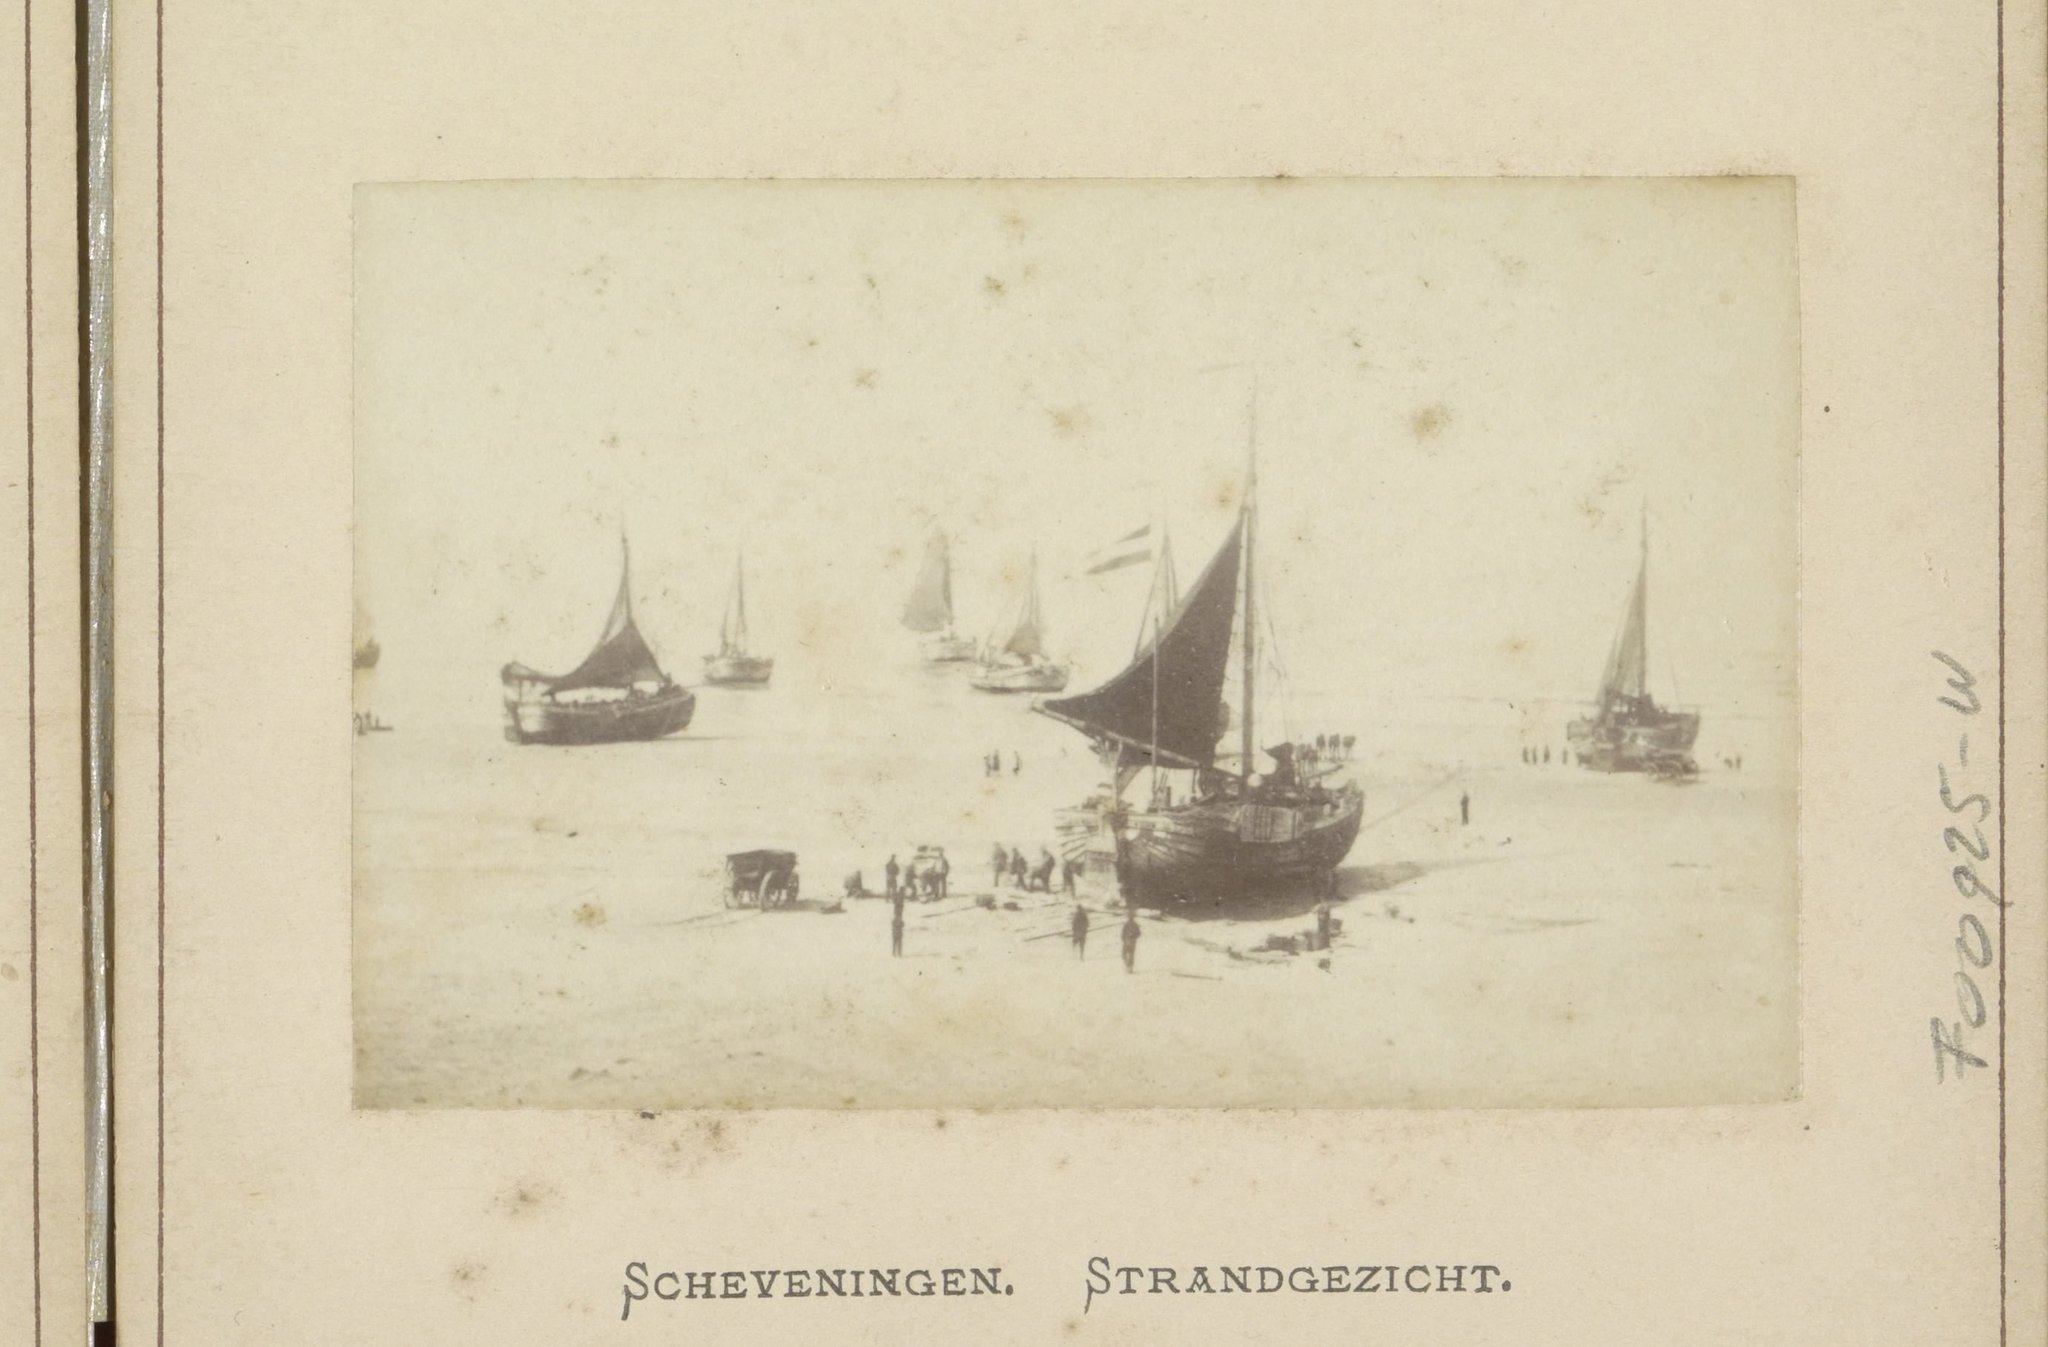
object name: reproduction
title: Scheveningen. Strandgezicht.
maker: andries jager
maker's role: publisher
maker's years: 1825-1905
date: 1860-1900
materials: cardboard, photographic support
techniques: albumen print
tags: ships, boats on land, beached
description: Onderdeel van Fotoalbum met opnames van steden in Noord- en Zuid-Holland en Utrecht.